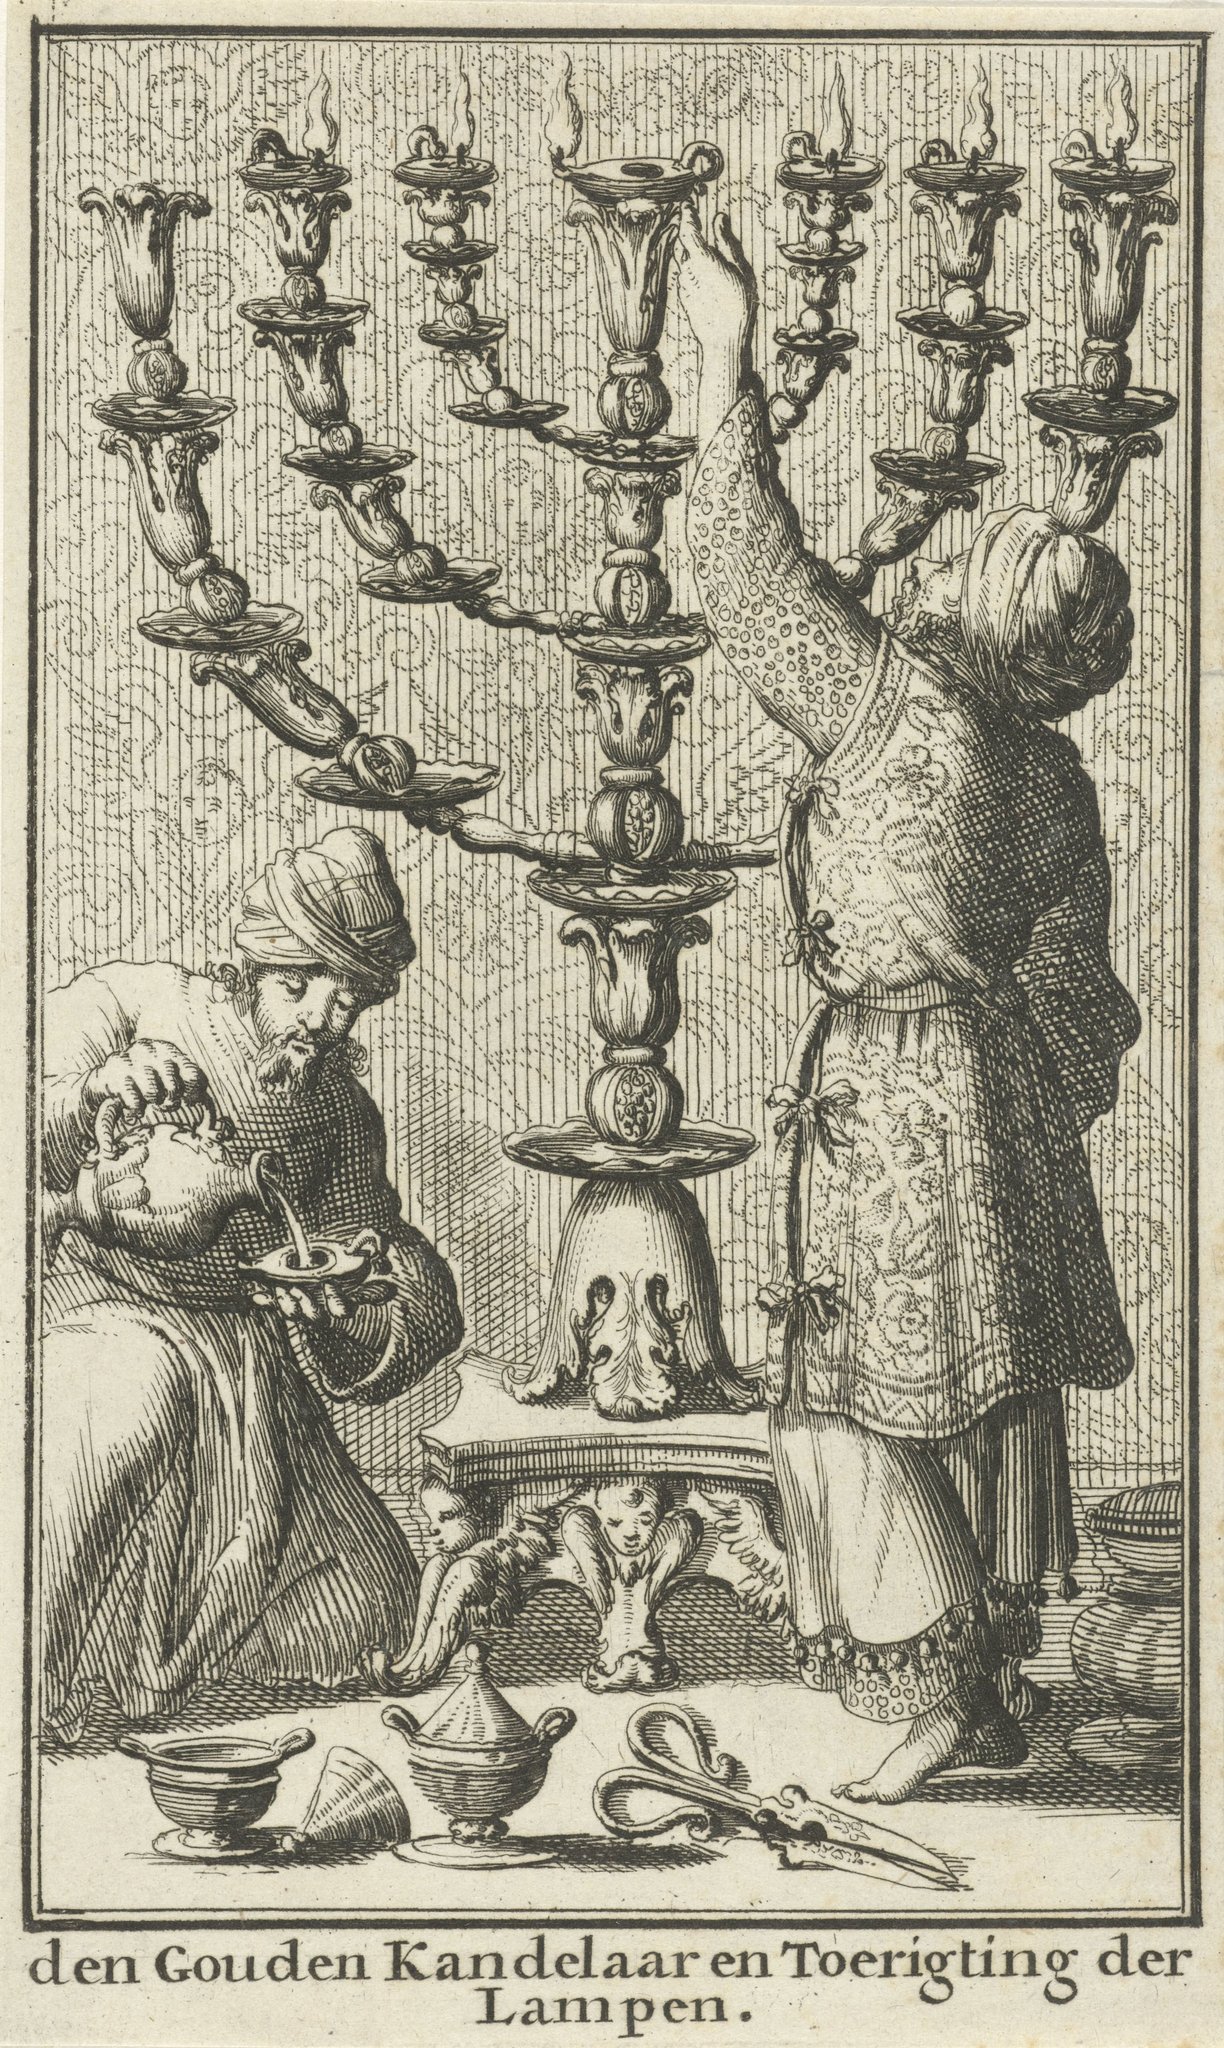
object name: book illustration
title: Gouden zevenarmige kandelaar of menora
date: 1683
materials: paper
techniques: etching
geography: amsterdam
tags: seven lamps ~ 'menorah'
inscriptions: collector's mark: Lugt 2228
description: Illustratie opgenomen in: Cunaeus, Petrus. De republyk der Hebreen, of gemeenebest der joden, 3 delen. Amsterdam: Wilhelmus Goeree, 1683, dl. 2, p. 302.